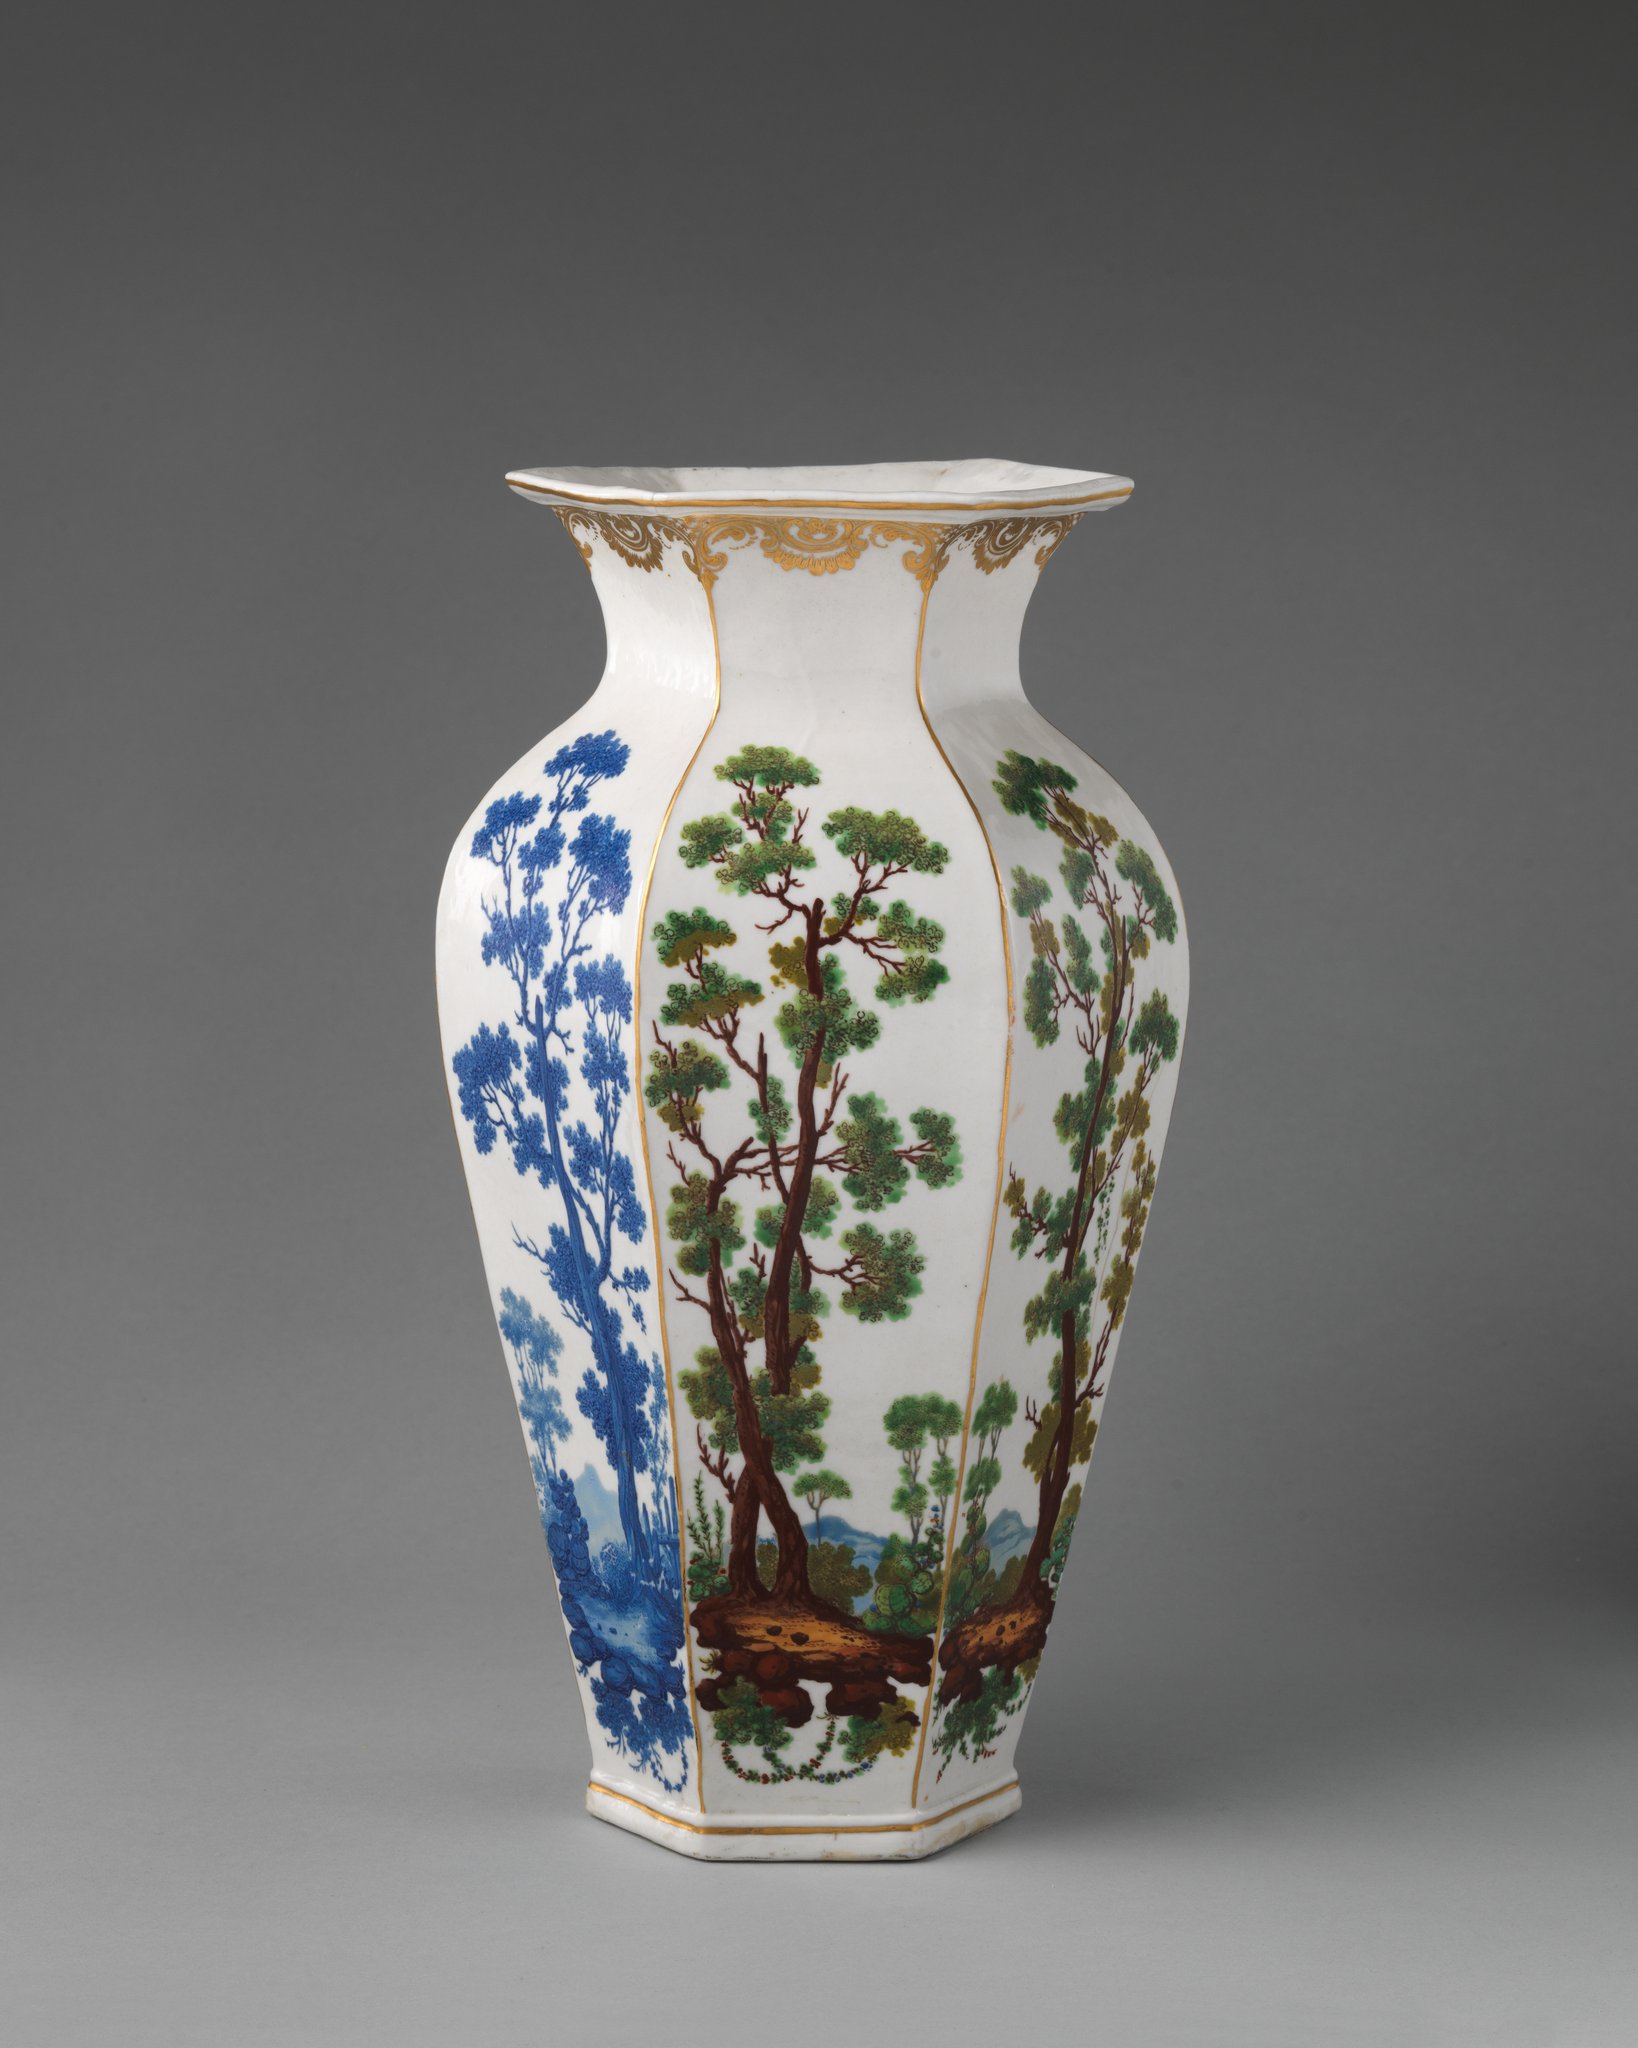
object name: beaker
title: Beaker (part of a garniture)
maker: bristol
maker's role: factory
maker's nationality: british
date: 1773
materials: hard paste porcelain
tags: trees